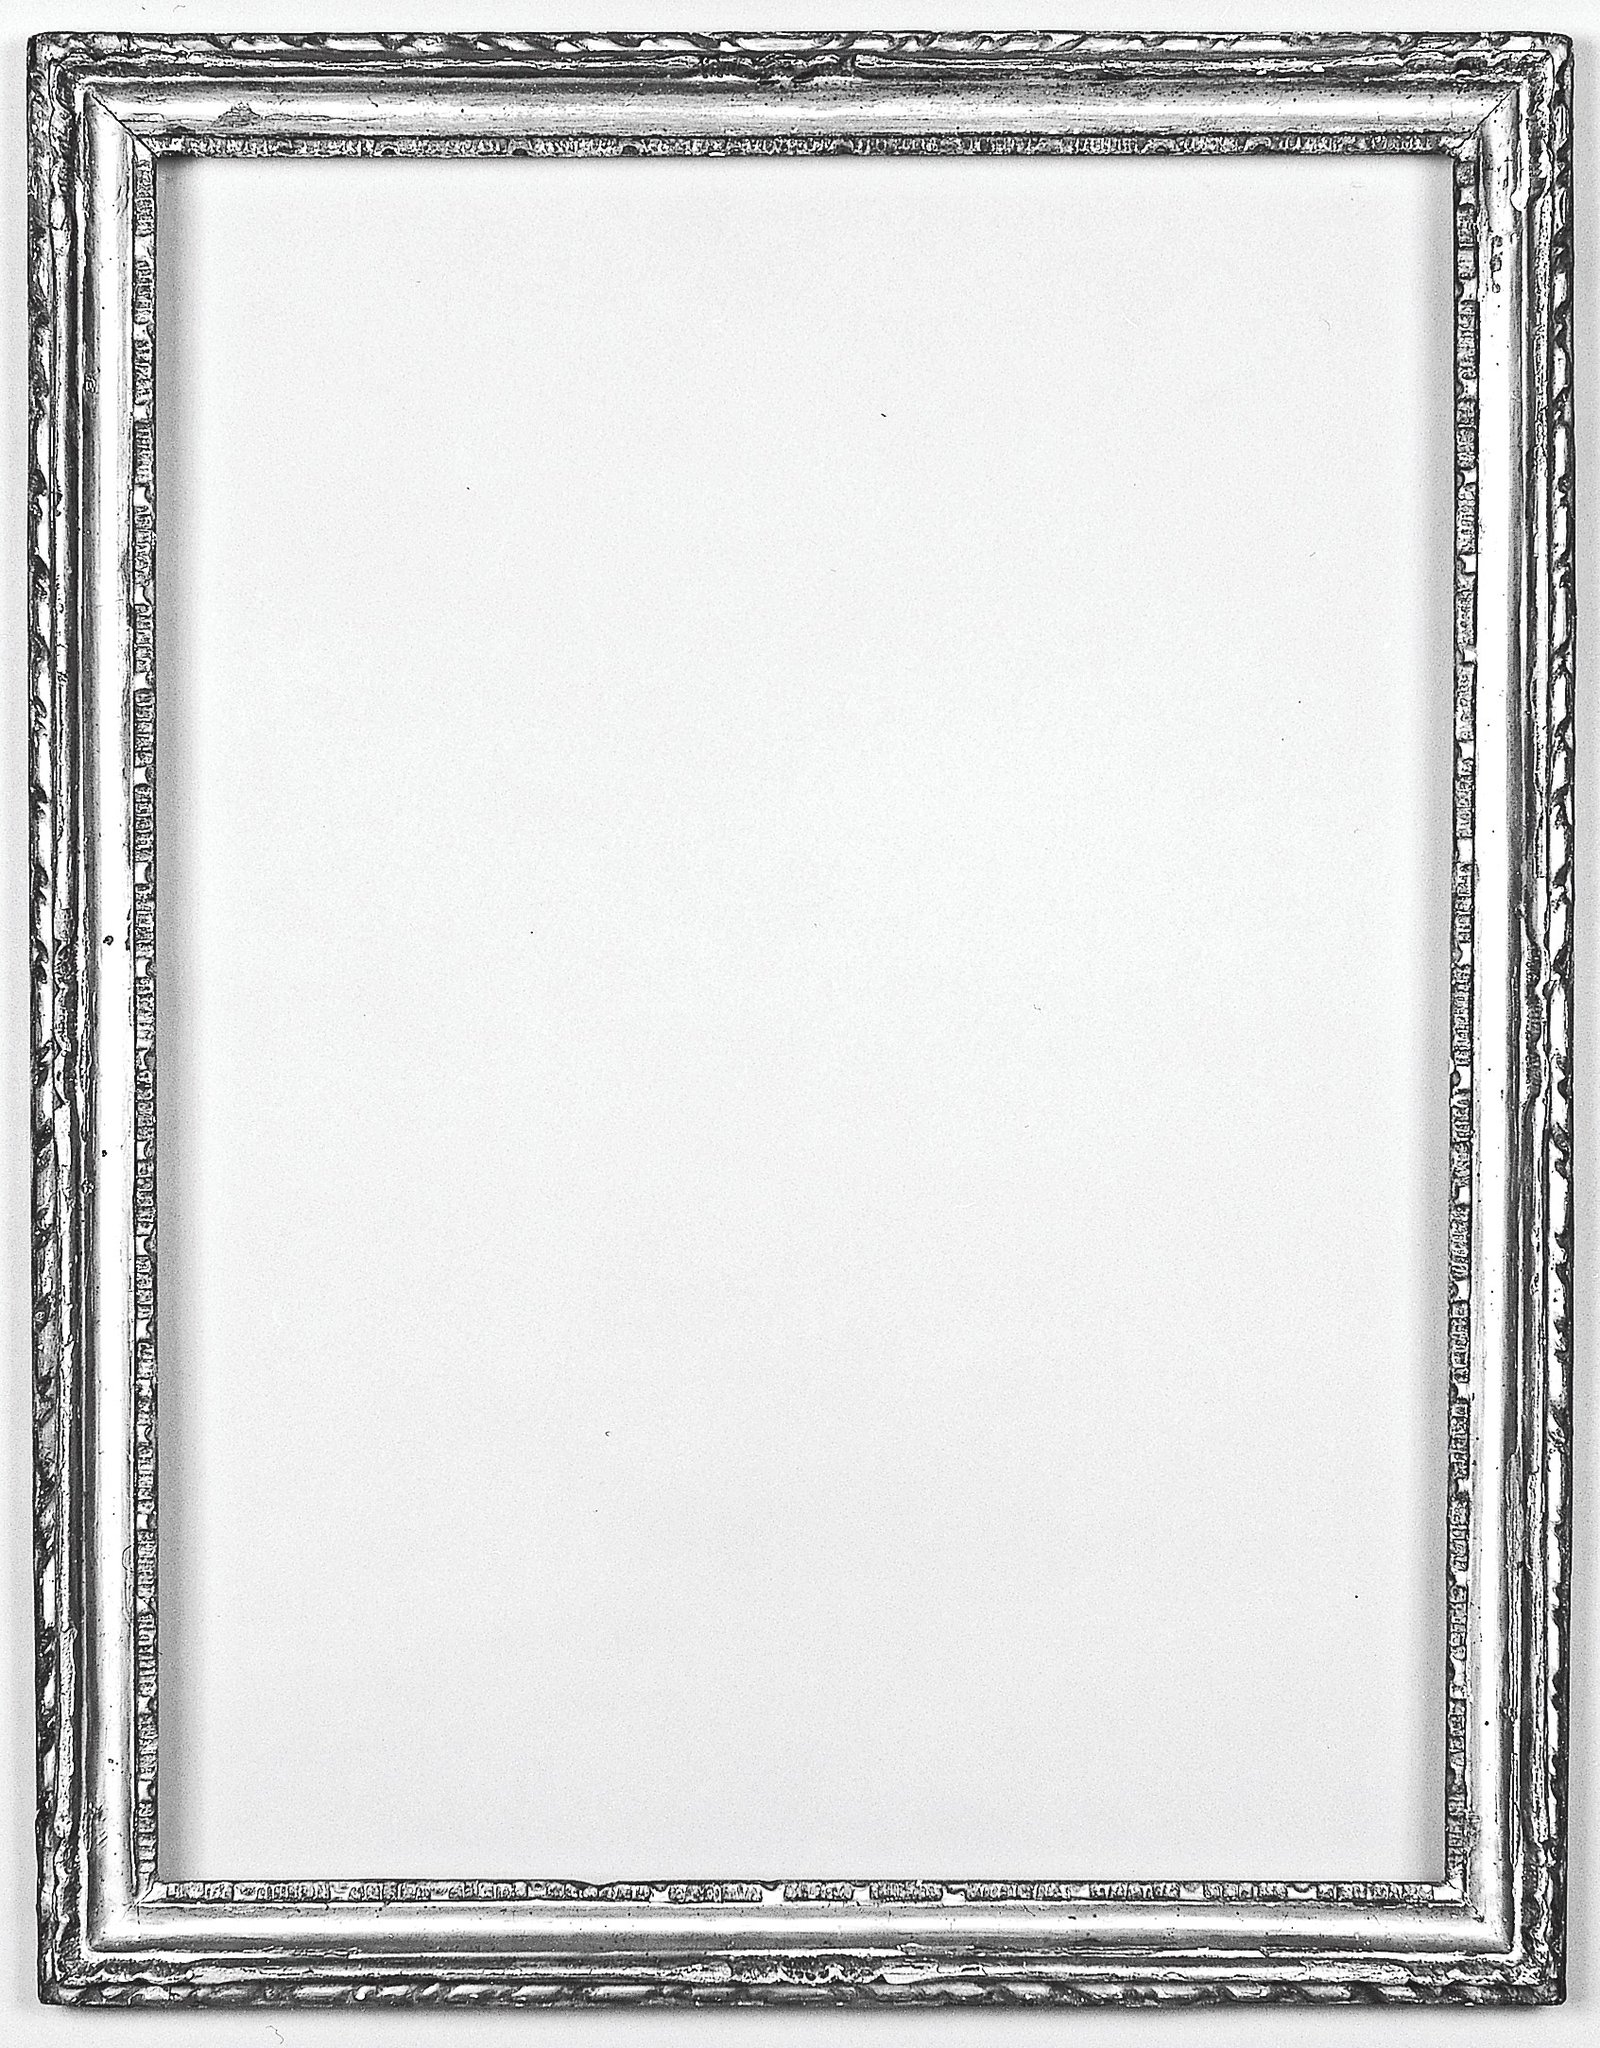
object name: frame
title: Rococo frame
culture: italian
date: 1734-1766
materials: wood